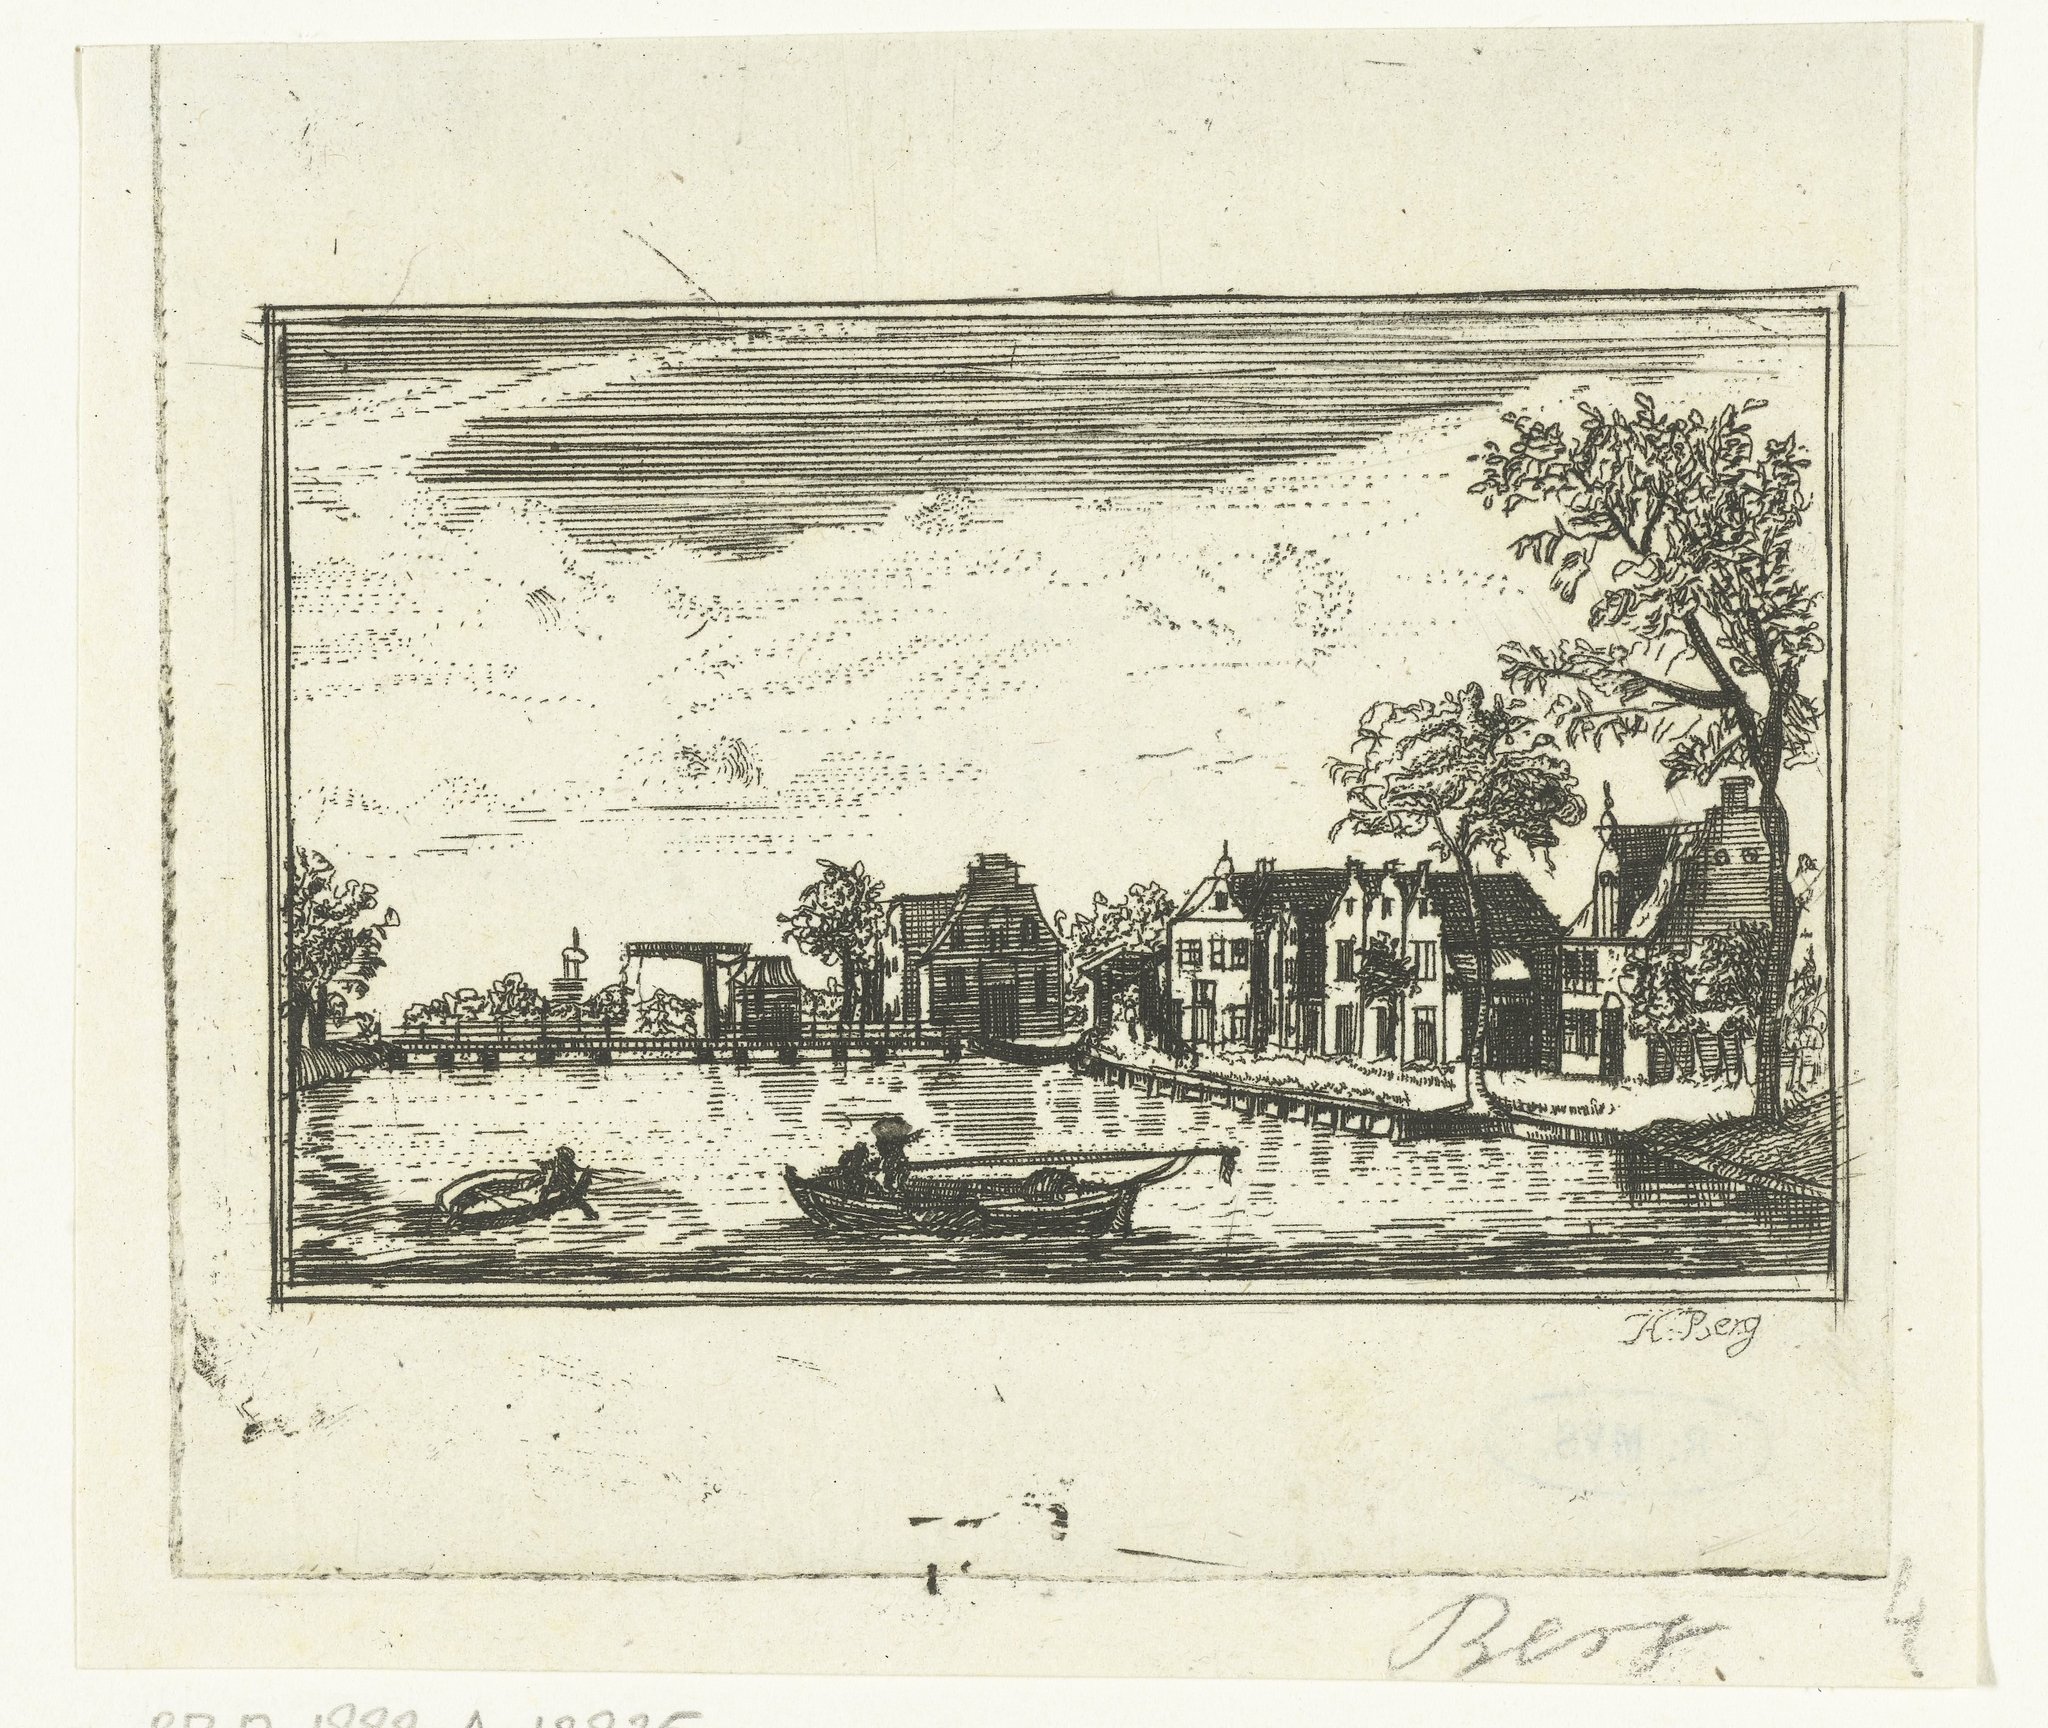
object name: print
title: Dorpsgezicht te Nieuwersluis met ophaalbrug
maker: hendrik berg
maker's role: print maker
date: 1765-1781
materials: paper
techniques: etching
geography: netherlands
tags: nieuwersluis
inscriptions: collector's mark: Lugt 2228